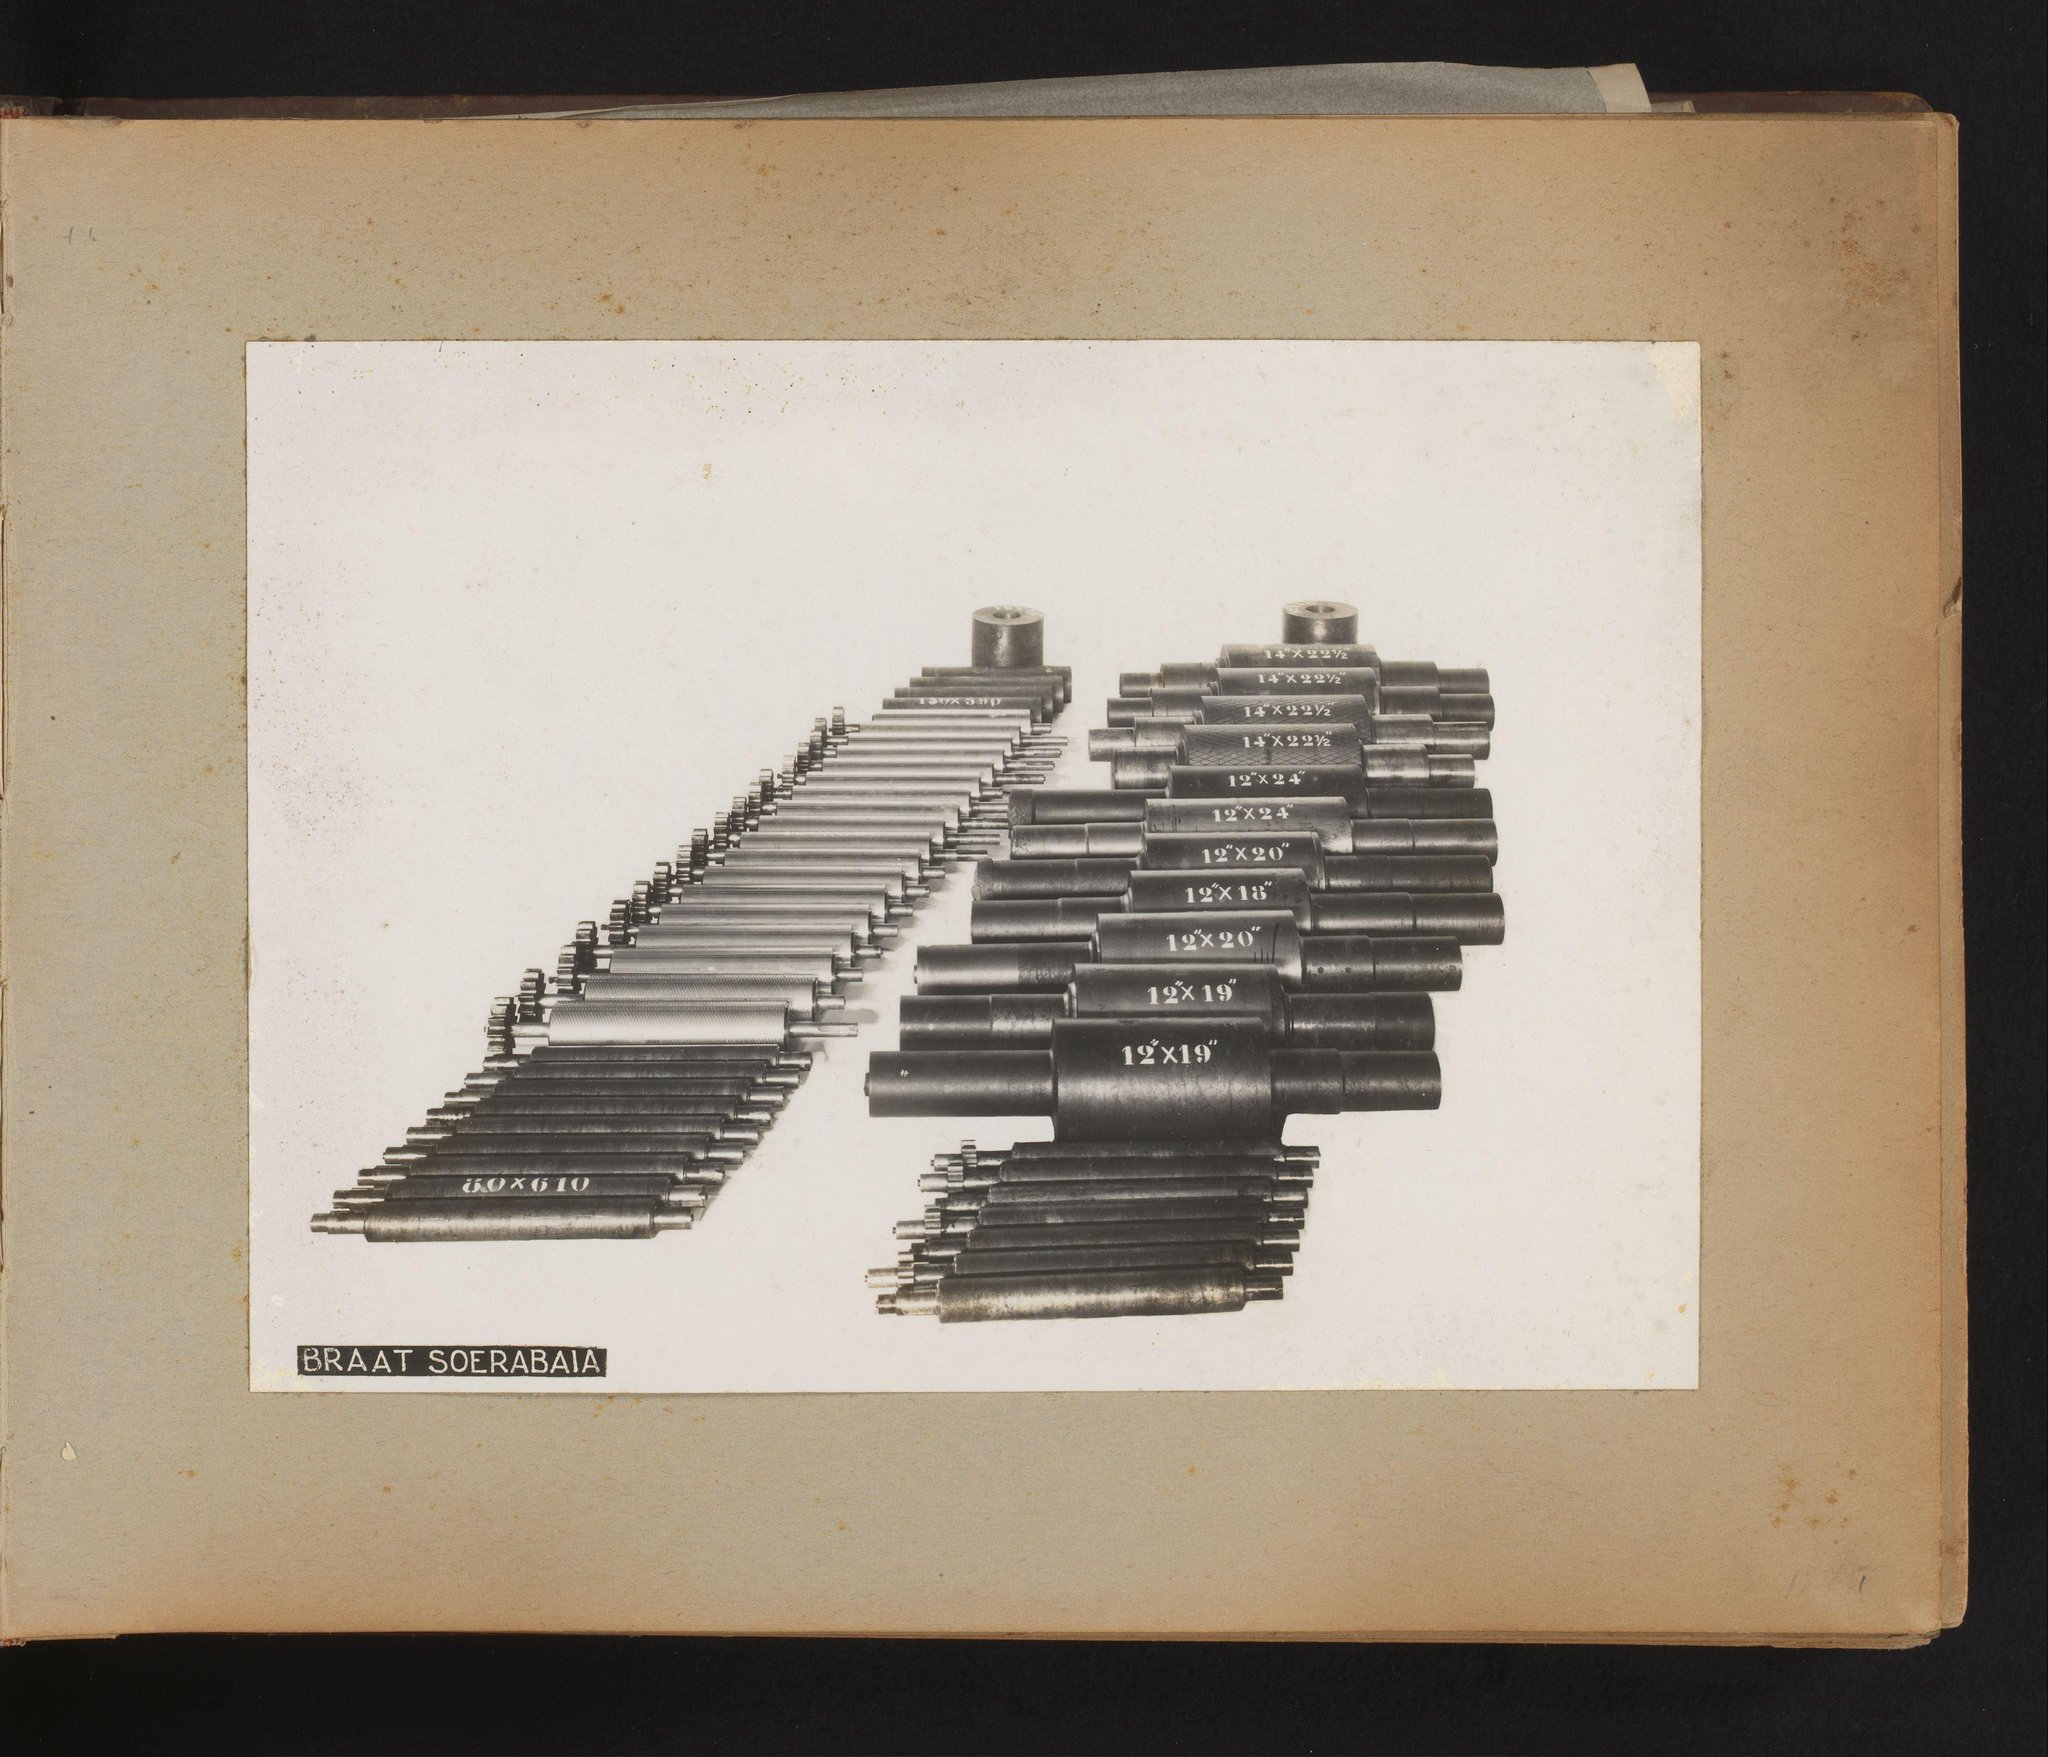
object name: photograph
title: Uitstalling van machineonderdelen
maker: Anonymous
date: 1931-1937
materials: cardboard, photographic support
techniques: gelatin silver print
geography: surabaya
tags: parts of machines, java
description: Albumblad met een foto van een uitstalling van machineonderdelen. Onderdeel van een fotoalbum met foto's van machines en constructies van de N.V. Machinefabriek Braat te Soerabaja, Soekaboemi en Tegal uit de periode 1931-1937.